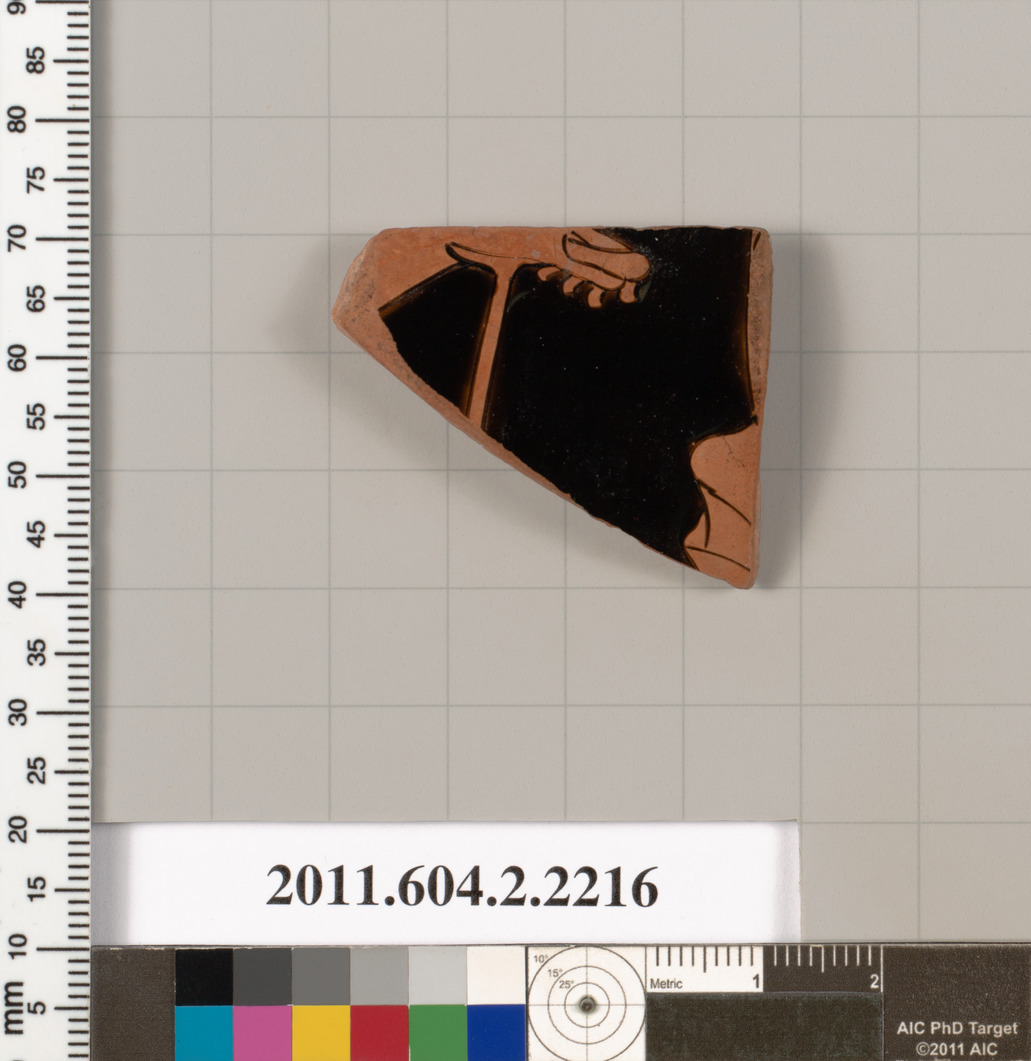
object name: pot fragment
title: Terracotta fragment of a pot; unglazed on the inside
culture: greek, attic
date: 475-451 BCE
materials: terracotta